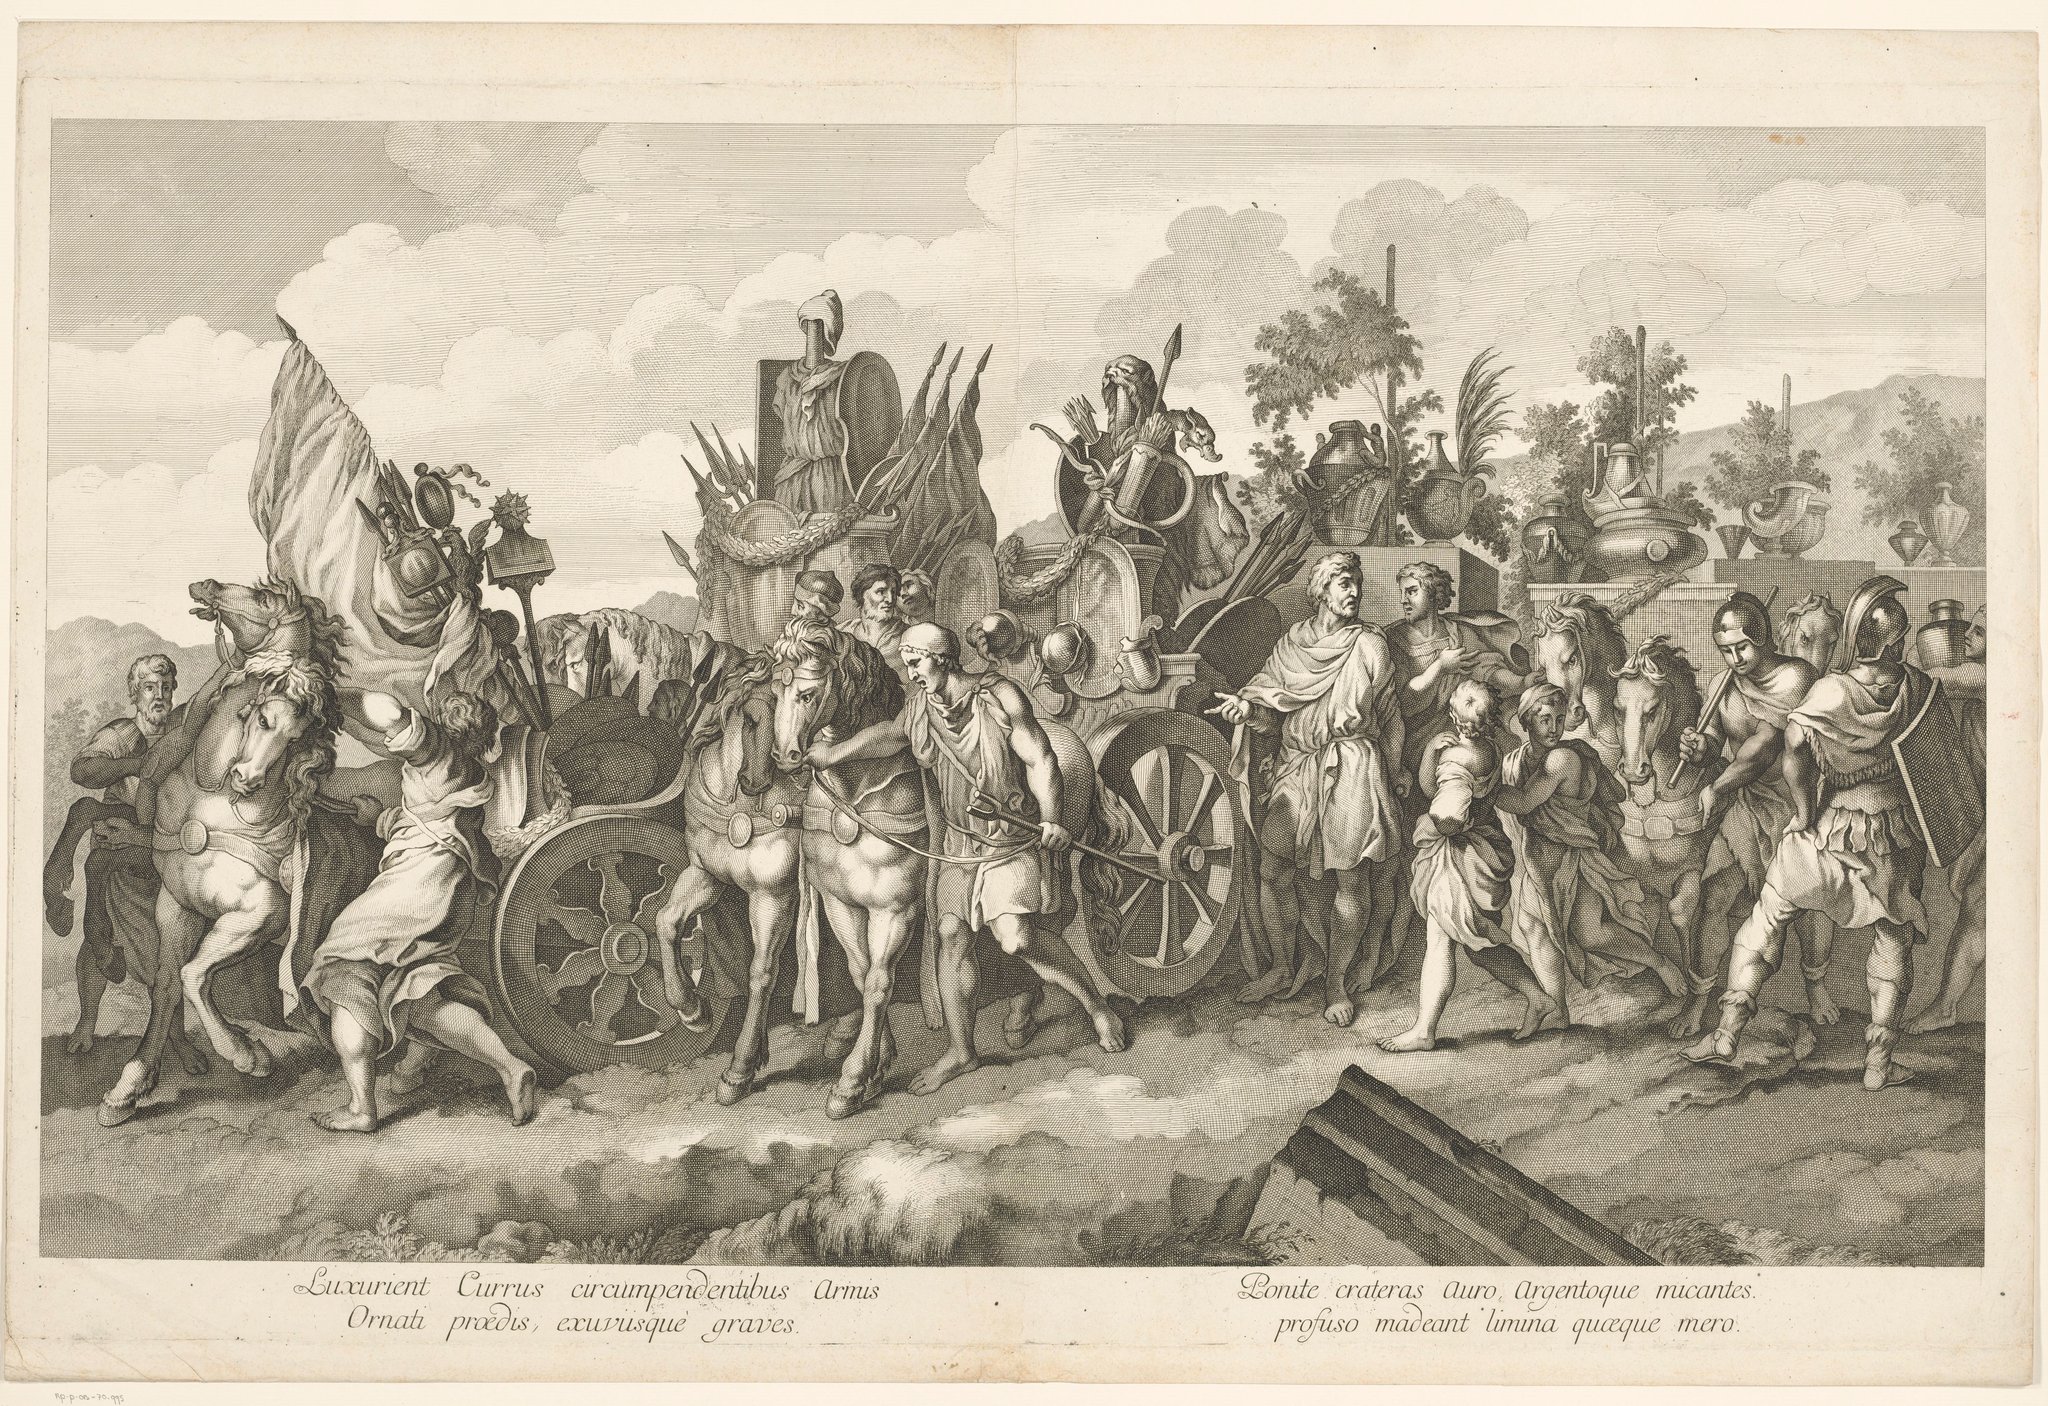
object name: print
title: MIlitaire stoet met oorlogsbuit op kar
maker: domenico rossetti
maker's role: print maker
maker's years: 1650-1736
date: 1660-1736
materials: paper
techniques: engraving, etching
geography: italy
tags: military parade, pageant (+ infantry), landscape with ruins, the soldier; the soldier's life, prisoner of war (after the battle), carrying off the spoils of war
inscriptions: collector's mark: Lugt 2228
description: Deze prent maakt deel uit van een reeks van twaalf prenten door verschillende prentmakers naar de grisailles door Gerard de Lairesse in Schloss Mannheim van de Triomftocht van Alexander de Grote in Babylon.